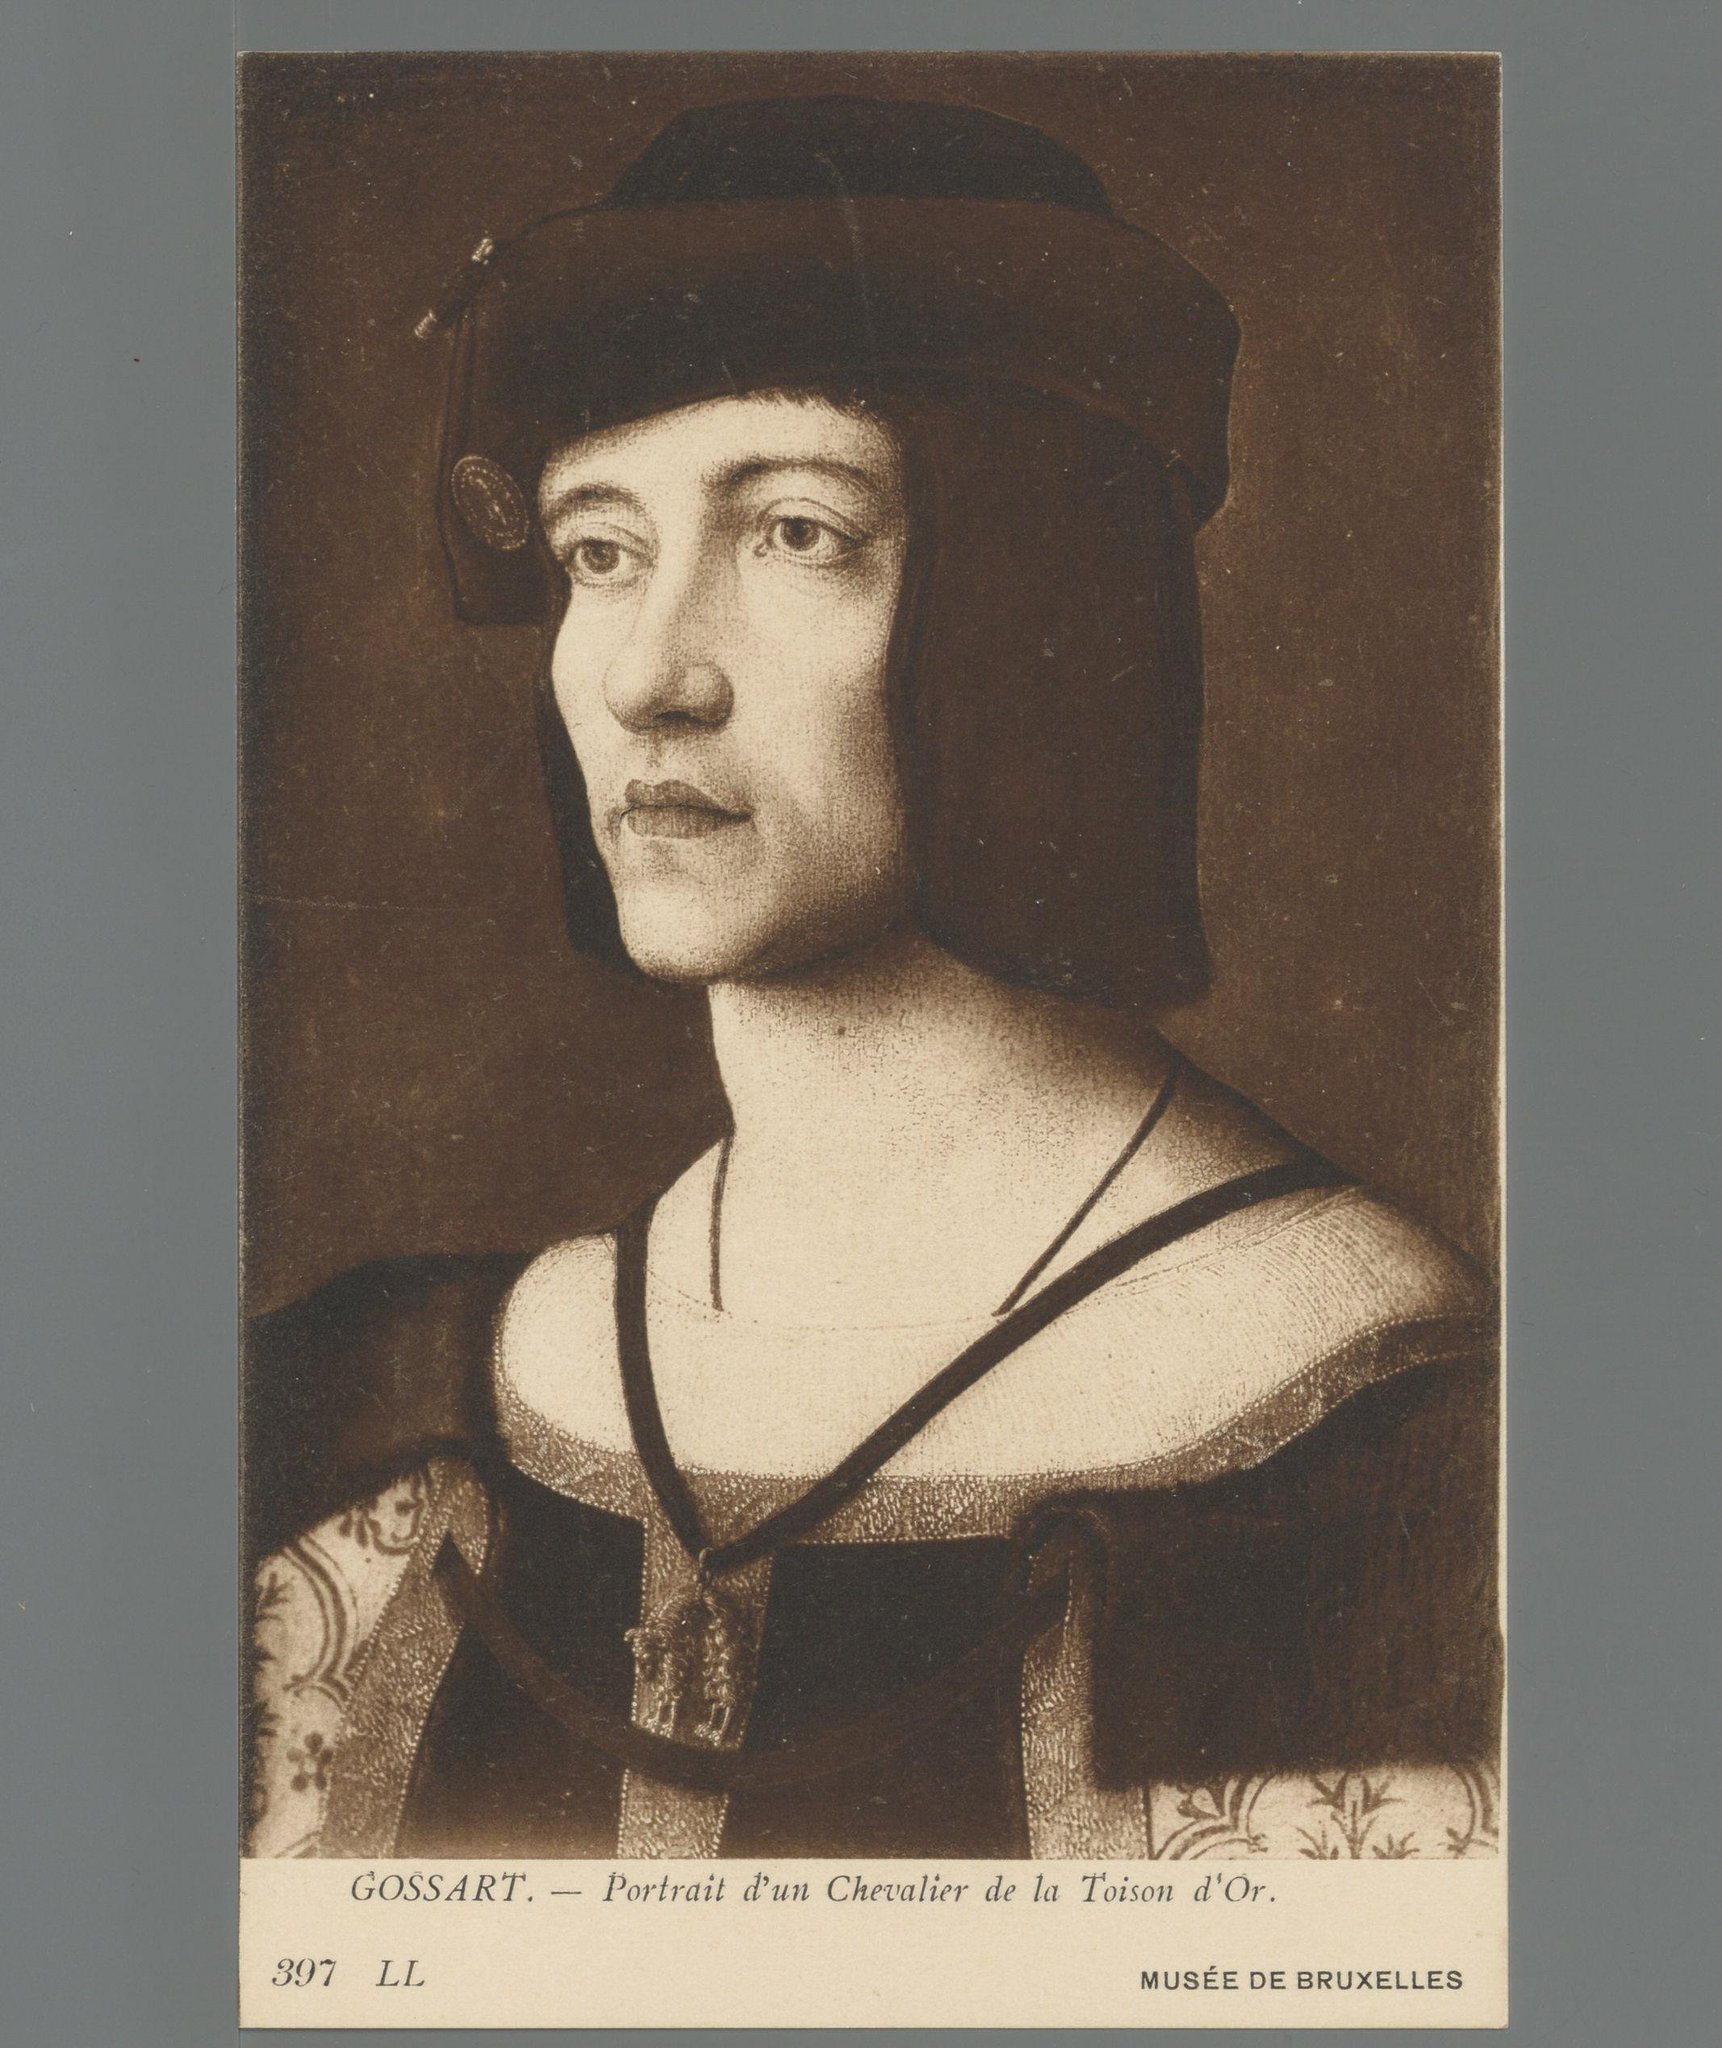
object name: photomechanical print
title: Gossart - Portrait d'un Chevalier de la Toison d'Or. Musée de Bruxelles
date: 1906-1913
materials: cardboard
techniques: photograph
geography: brussels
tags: permanent exhibition, museum, picture, painting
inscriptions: collector's mark: ‘AFE v S’